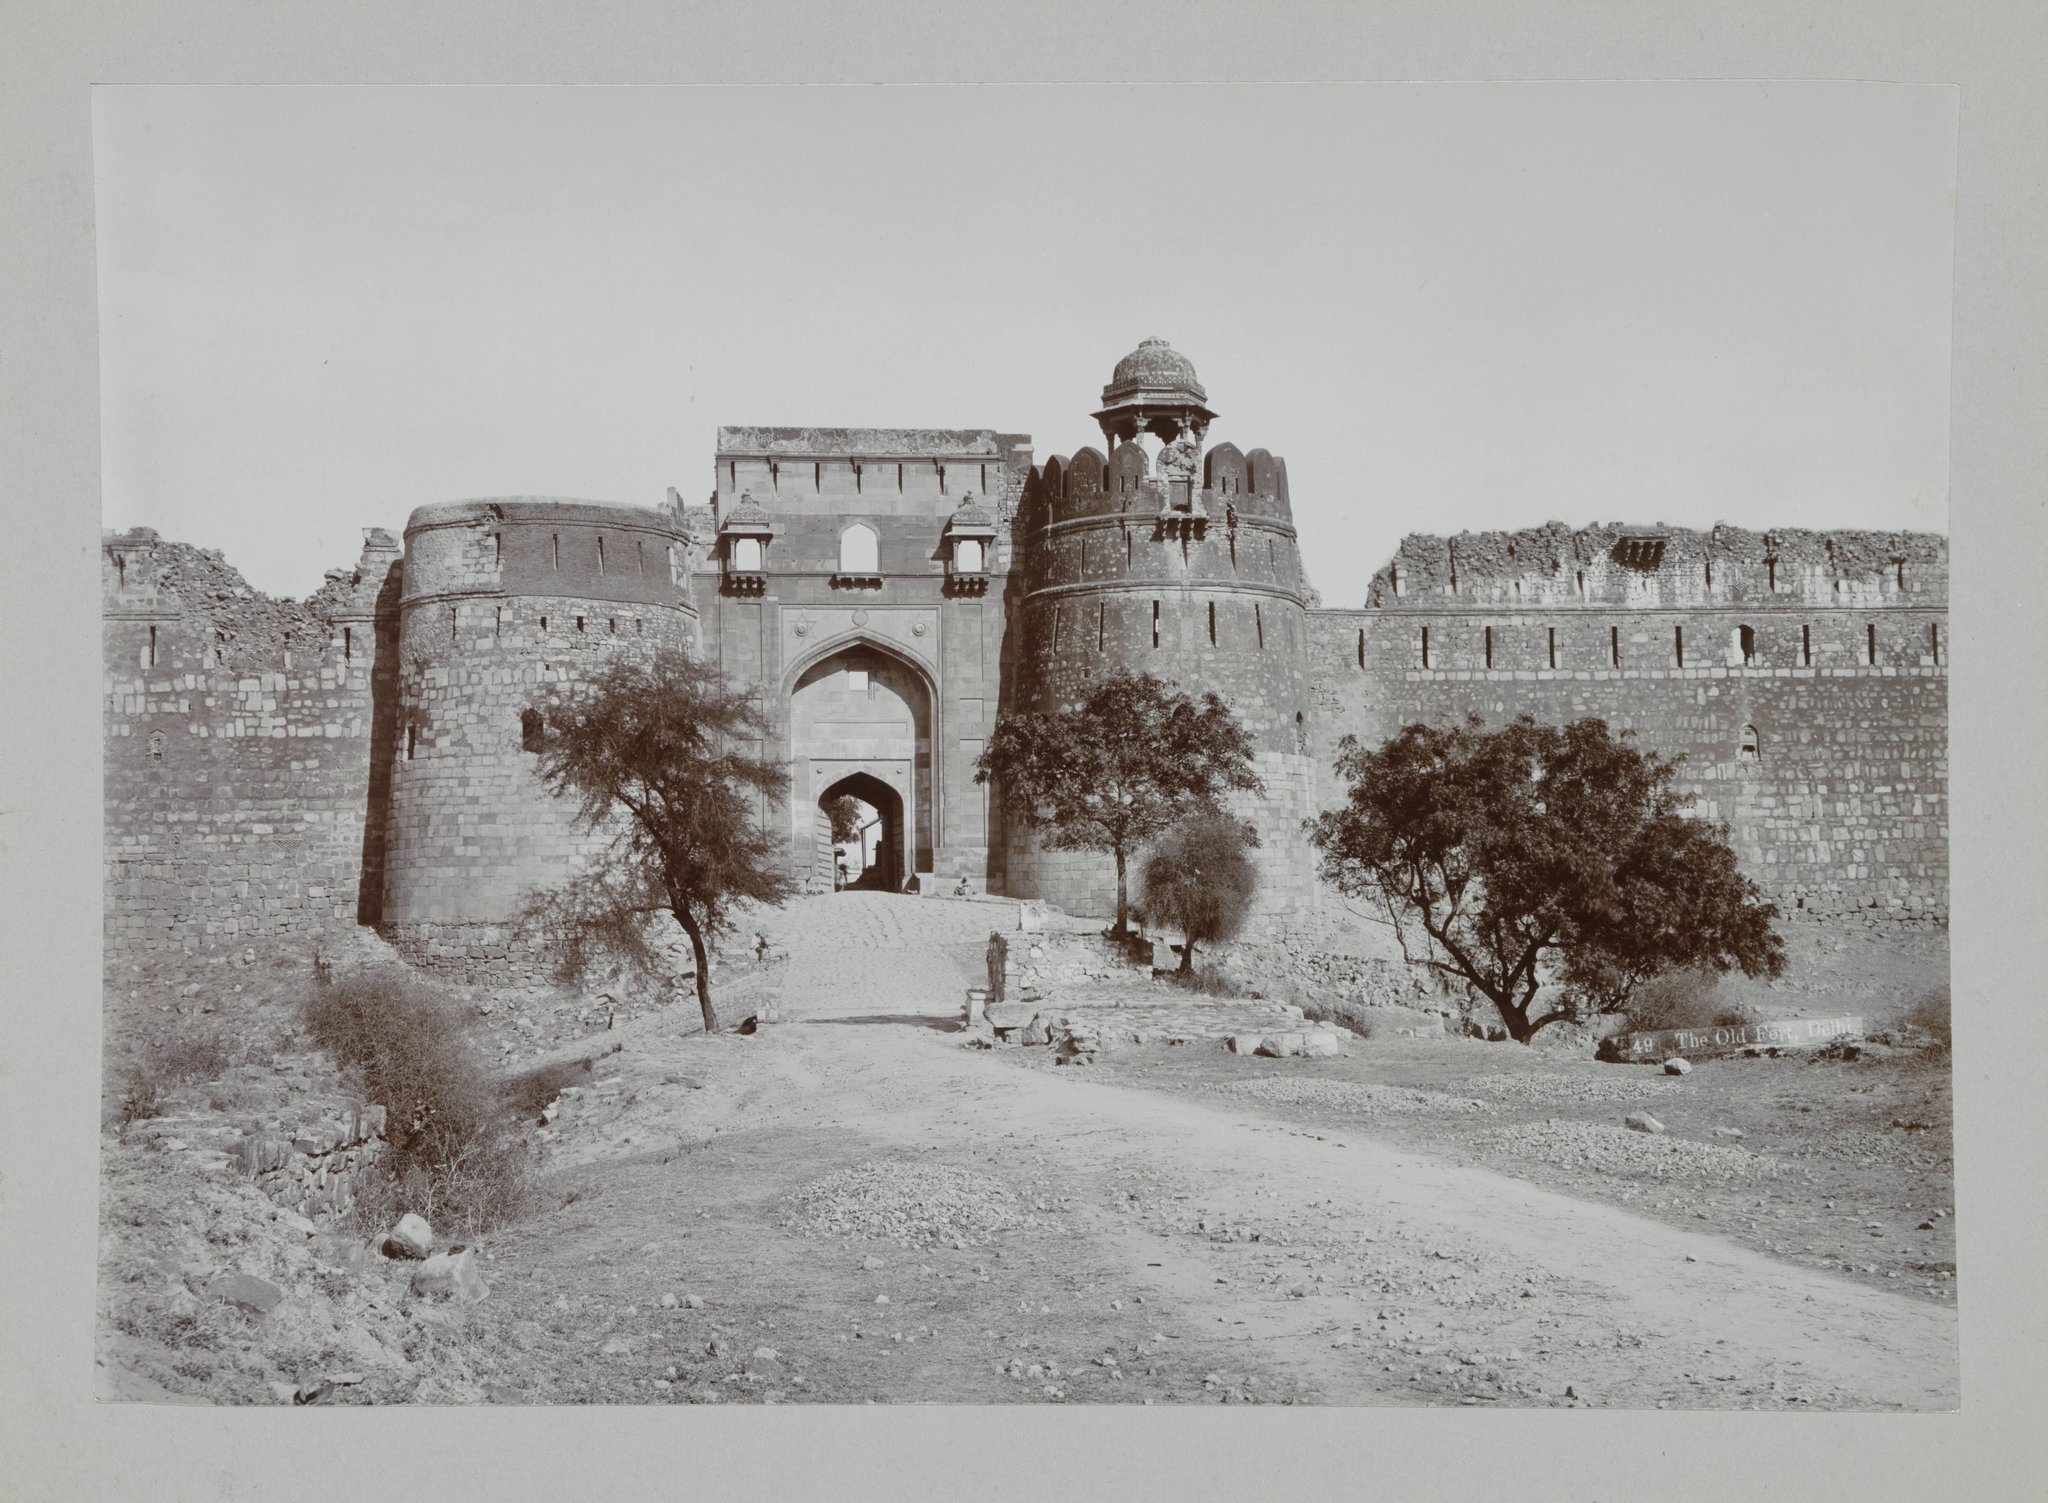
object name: photograph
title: Gateway to the Old Fort in Delhi, India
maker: Anonymous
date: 1895-1915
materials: cardboard, paper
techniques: gelatin silver print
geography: delhi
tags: delhi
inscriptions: annotation: ‘36. Oude Delhipoort.’, inscription: ‘49 The Old Fort, Delhi’